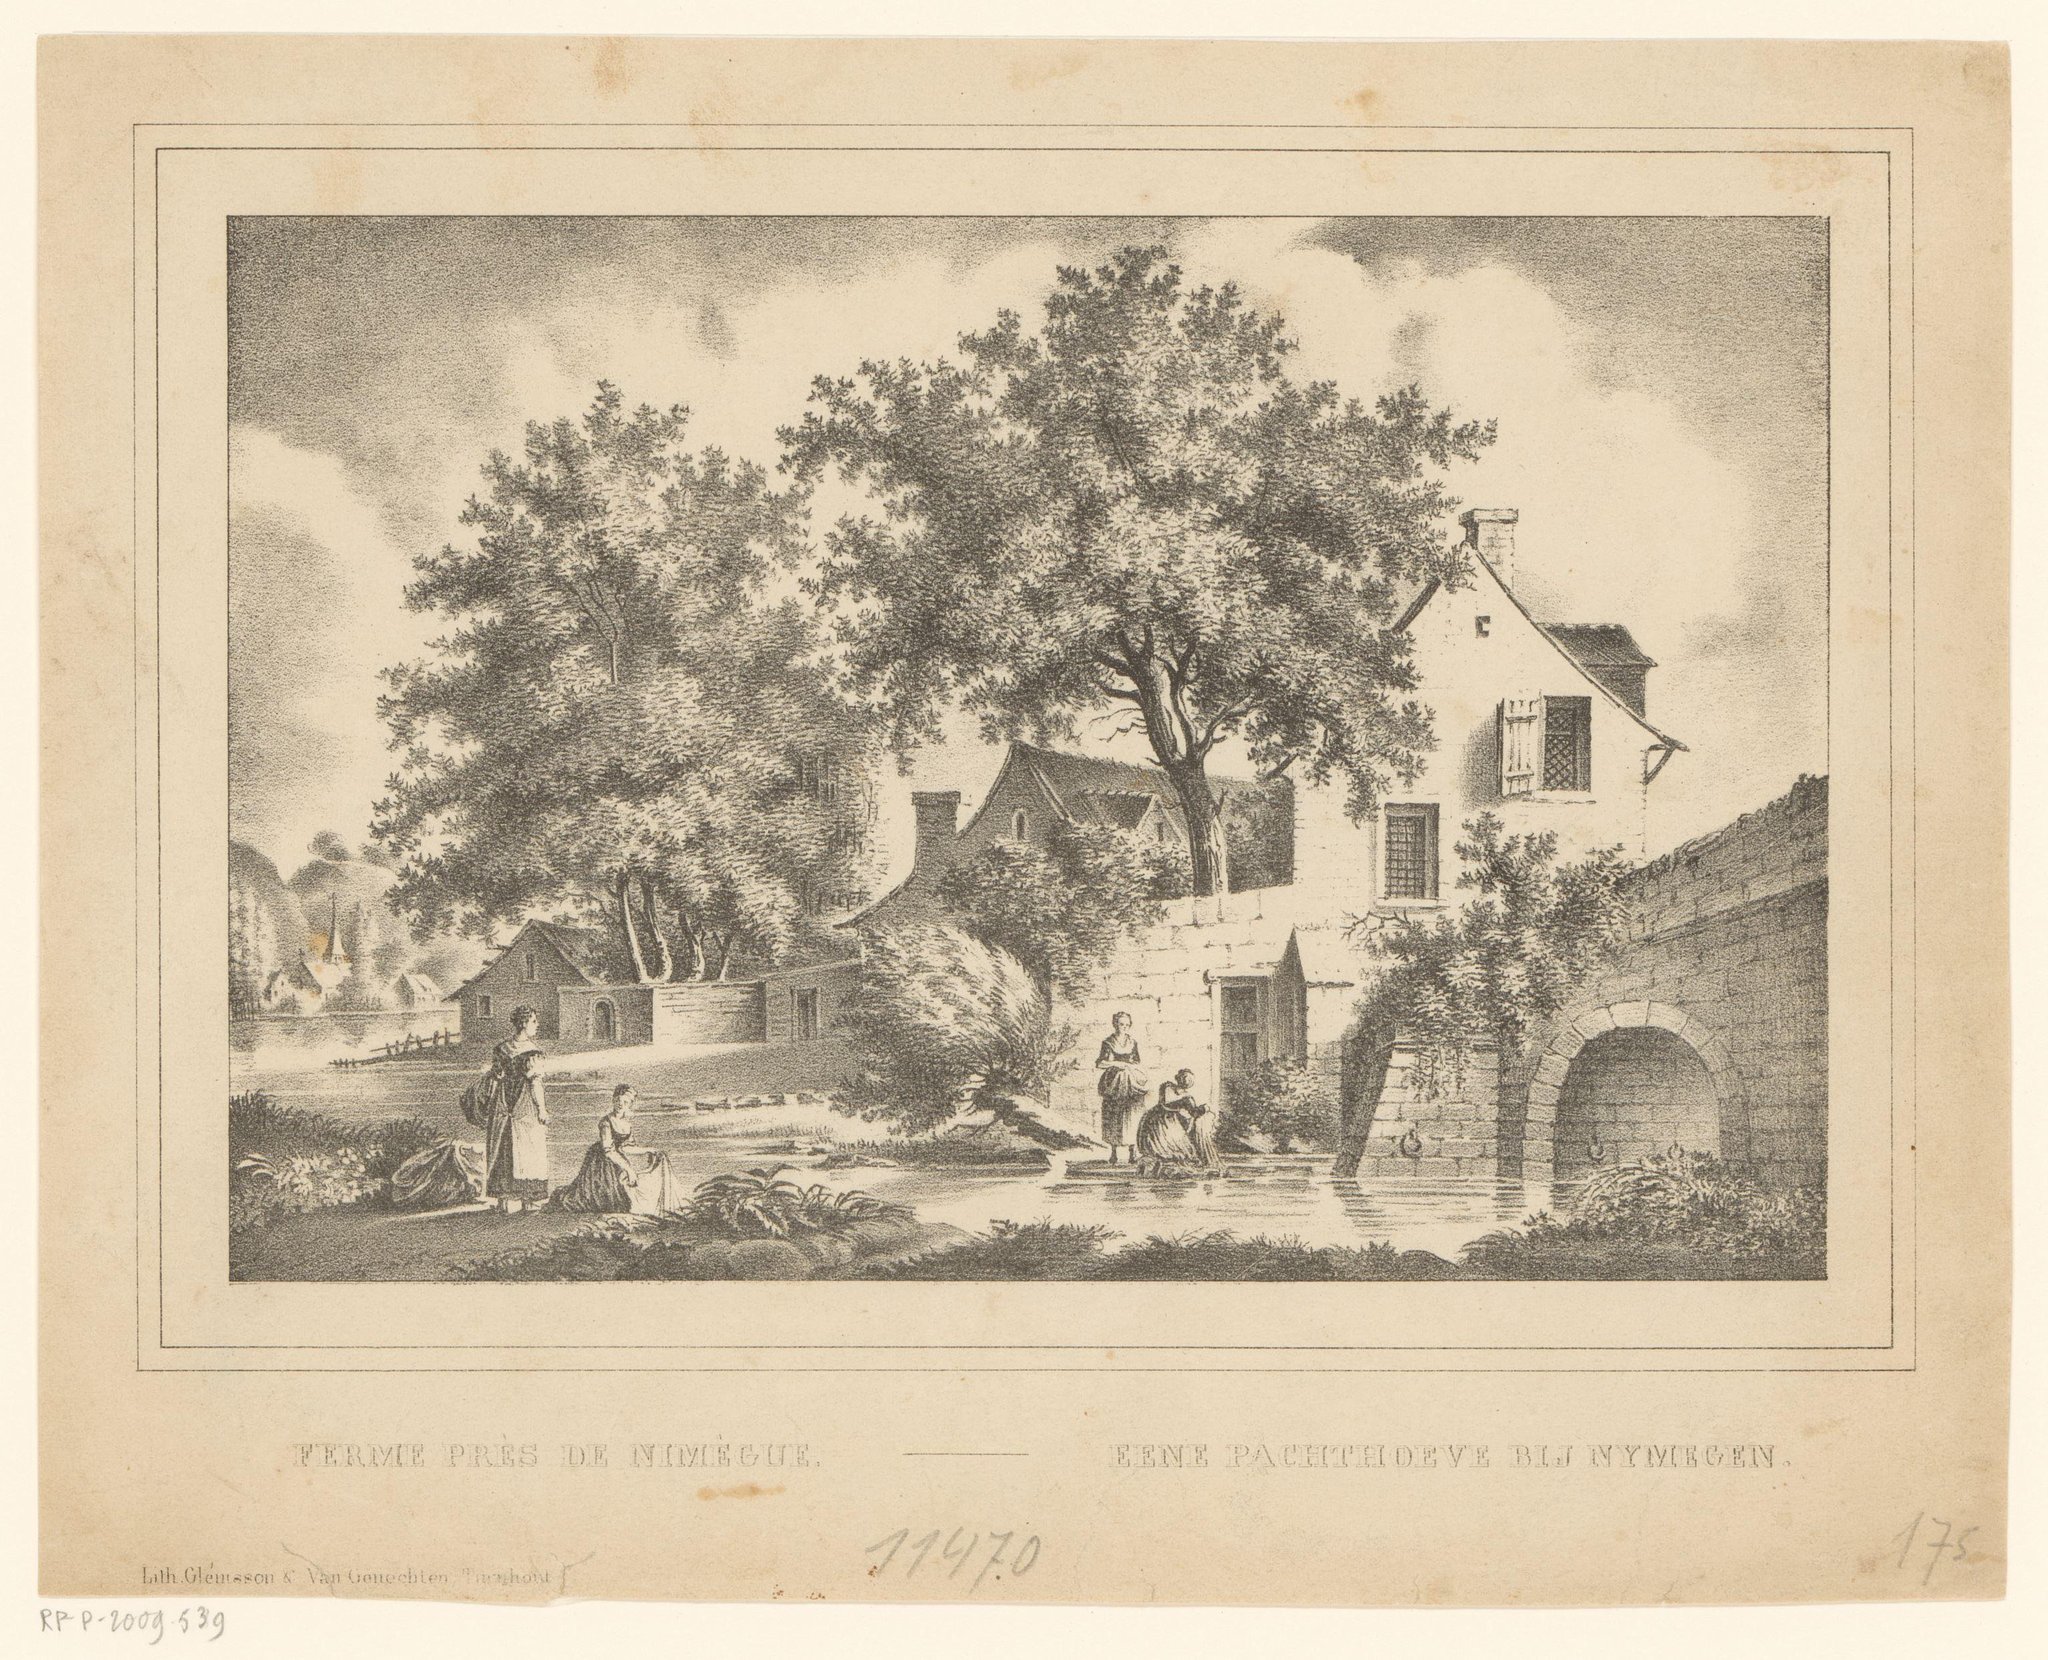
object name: print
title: Ferme près de Nimèghe / Eene pachthoeve bij Nymegen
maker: Anonymous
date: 1833-1856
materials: paper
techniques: lithograph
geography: turnhout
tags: laundering, farm (building)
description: Gezicht op een pachthoeve bij Nijmegen. Een rivier stroomt langs de hoeve naar rechts onder een stenen brug door. Aan de oever zijn vrouwen de was aan het doen in de rivier. Links in de verte een kerk.